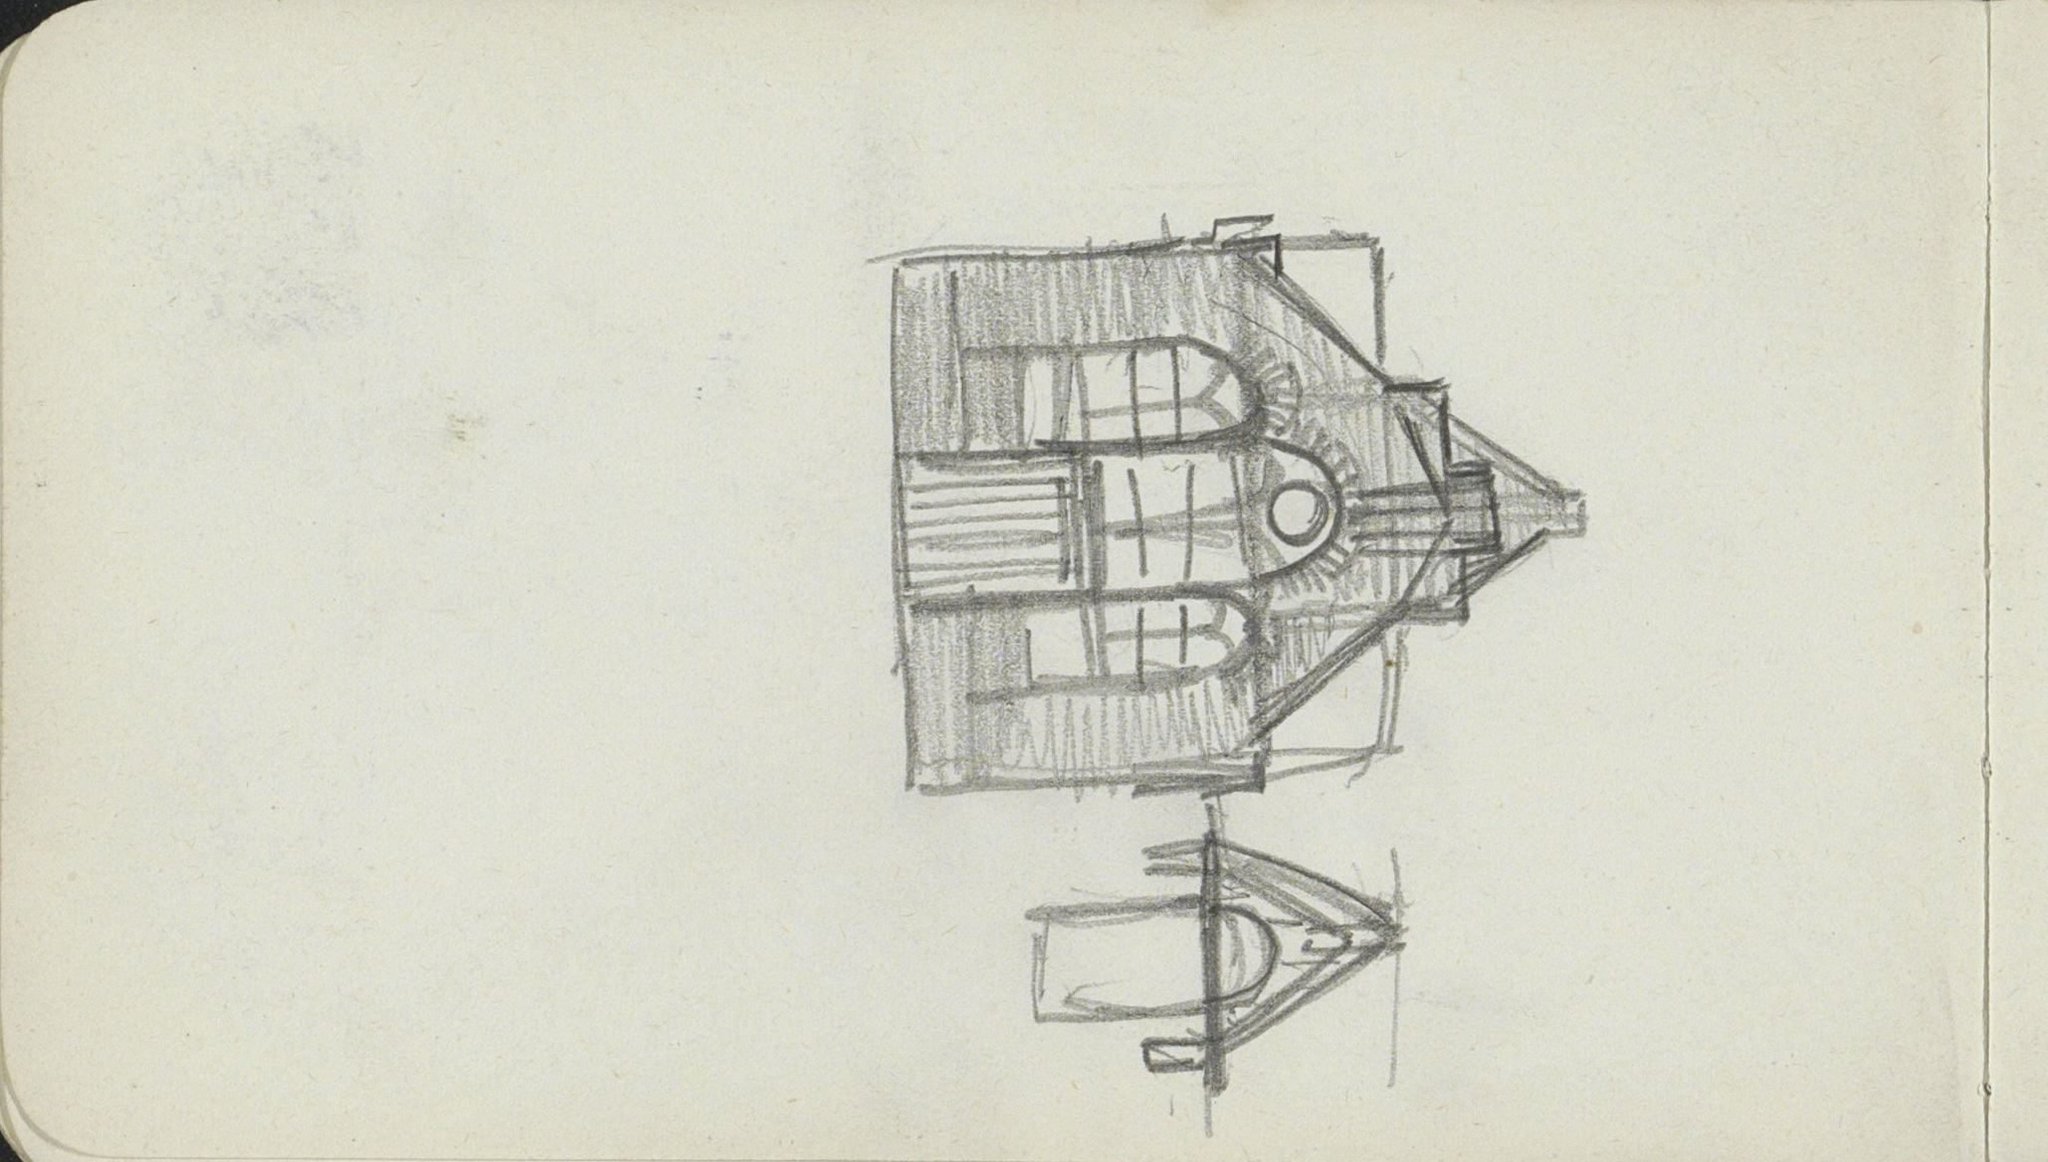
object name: sketchbook leaf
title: Vooraanzicht van een kerk en een Romaans venster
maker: carel adolph lion cachet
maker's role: draughtsman, print maker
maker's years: 1864-1945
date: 1905-1906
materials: paper, pencil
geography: vreeland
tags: window, church (exterior)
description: Blad 10 verso uit een schetsboek met 34 bladen.